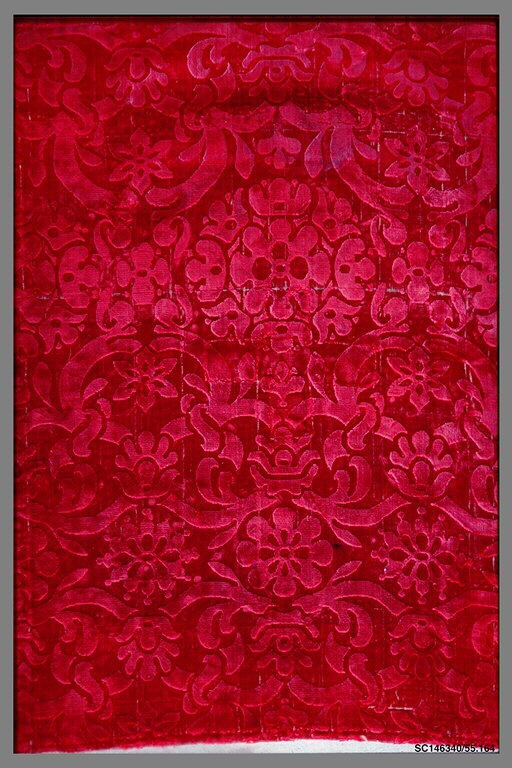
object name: piece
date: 1501-1600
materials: silk